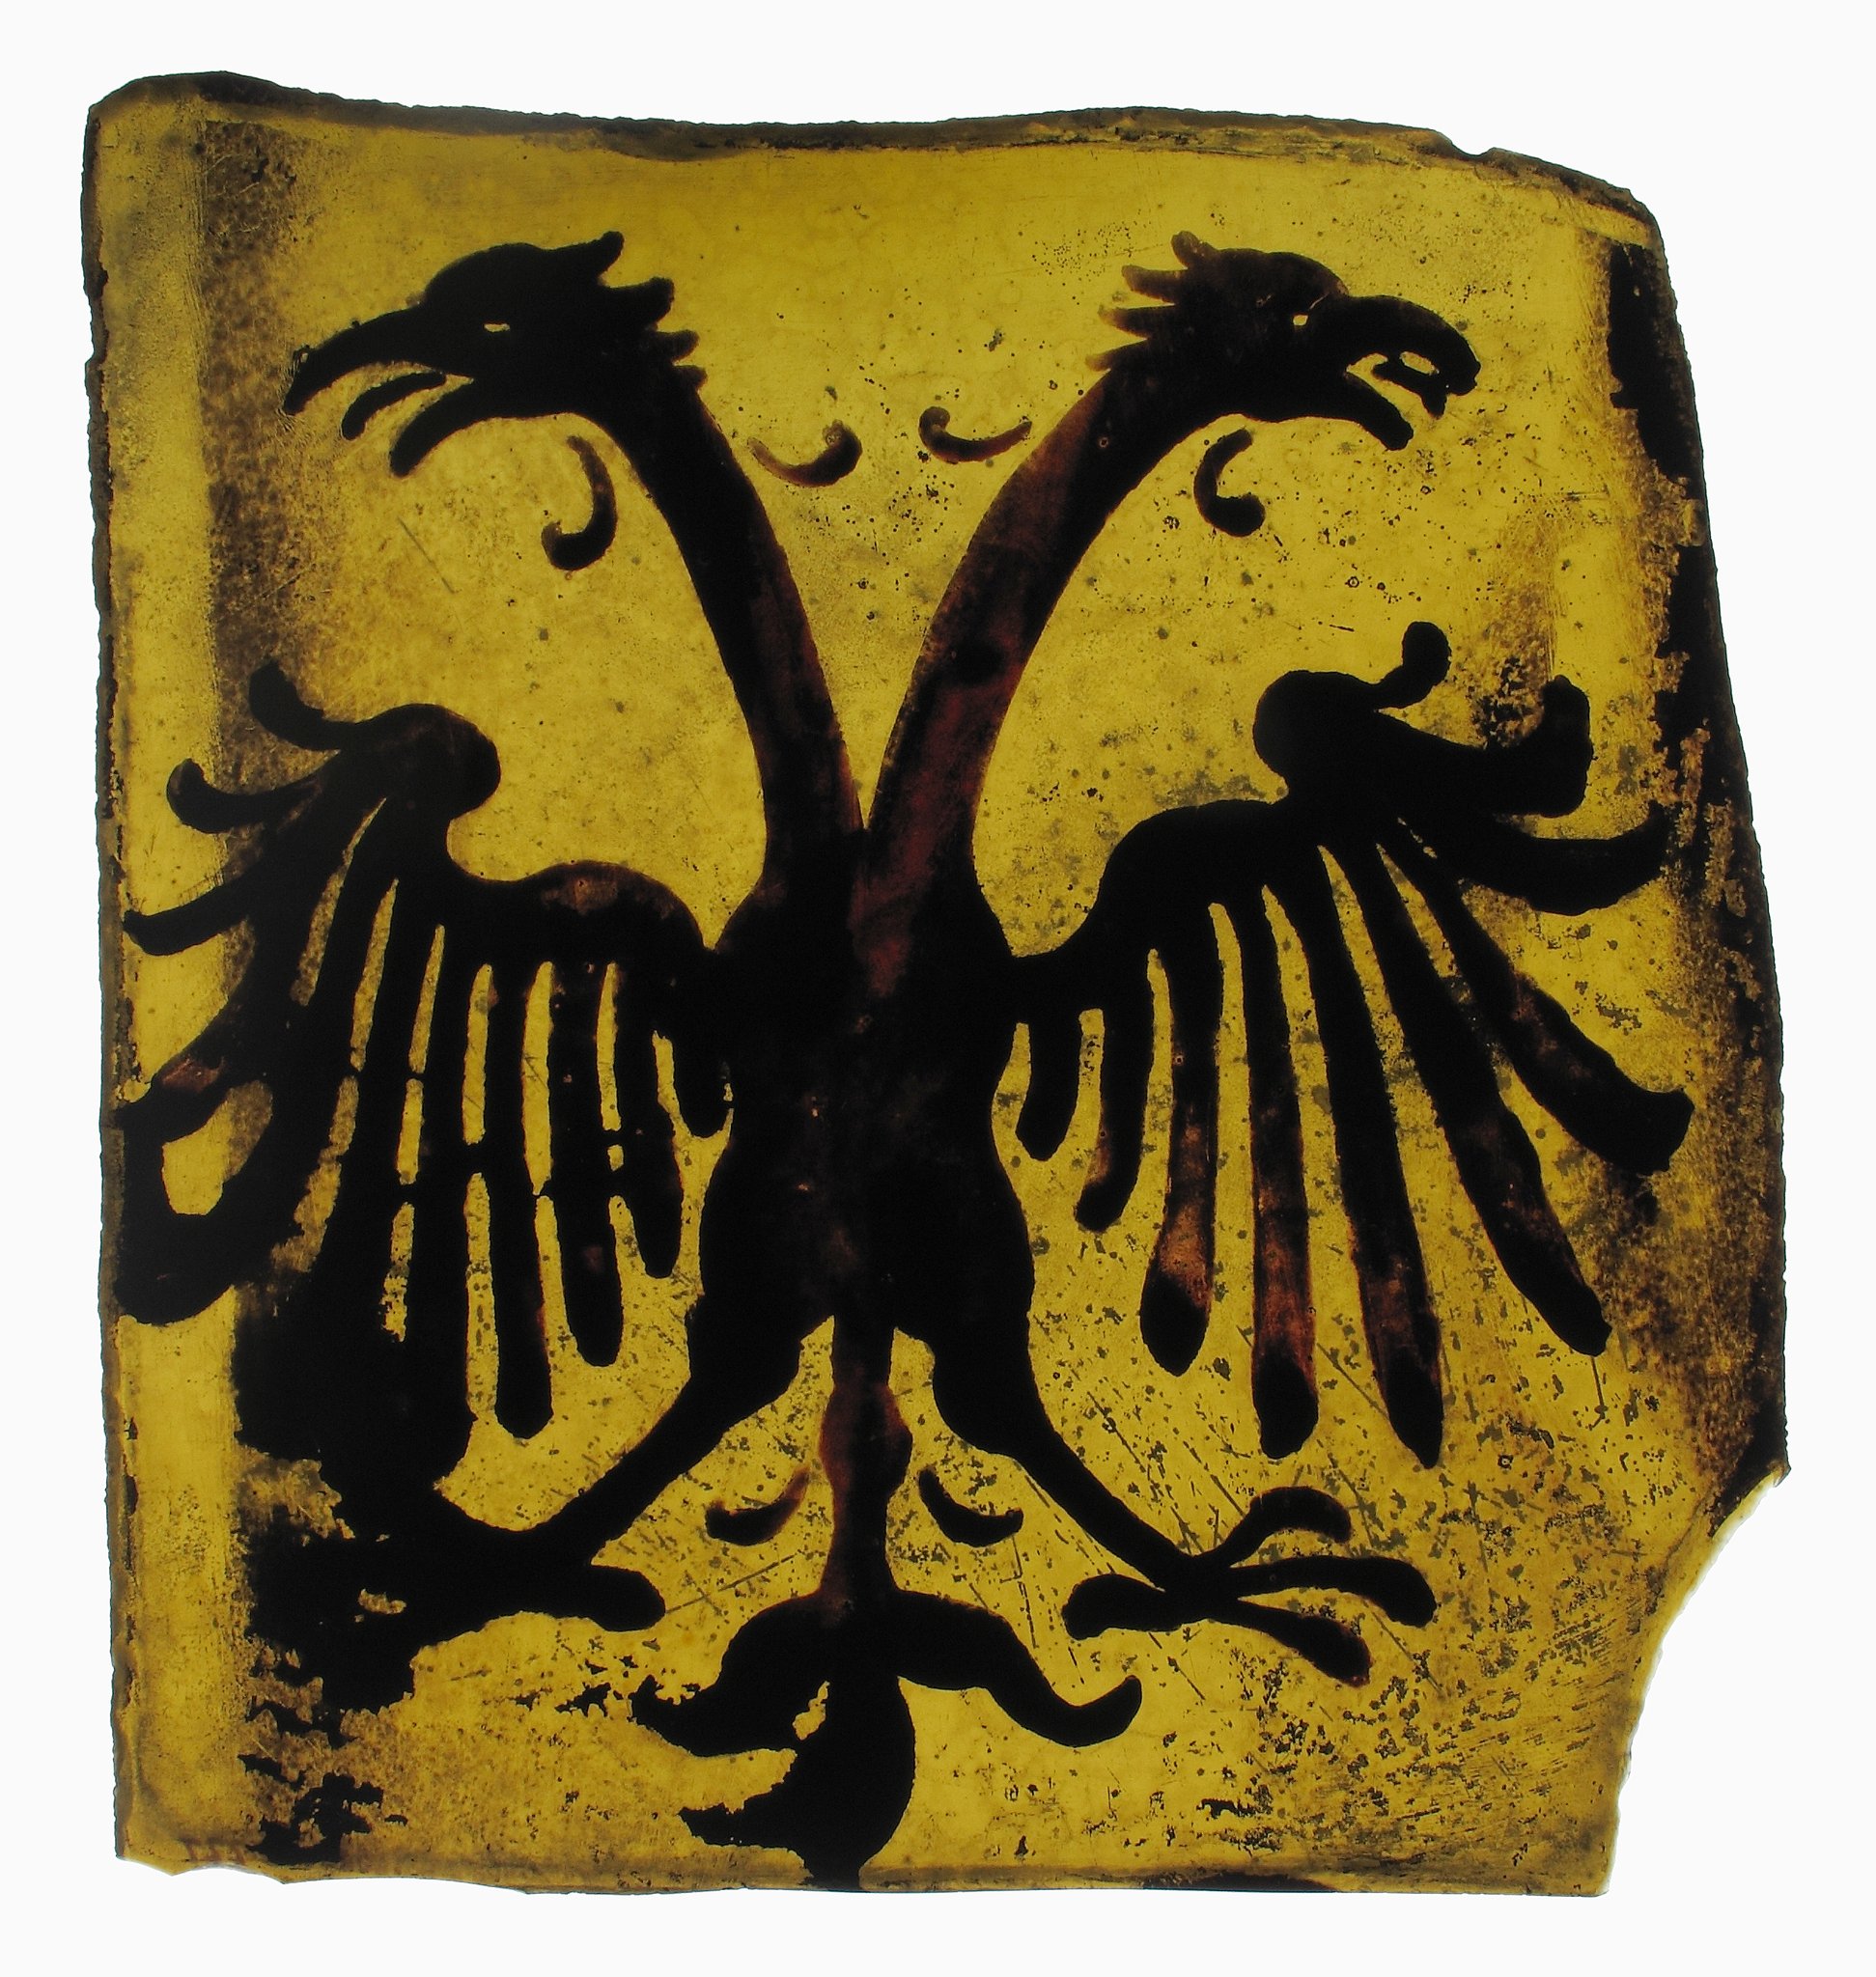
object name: stained glass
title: Glass Fragment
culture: european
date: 1401-1500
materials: glass, paint, pigment